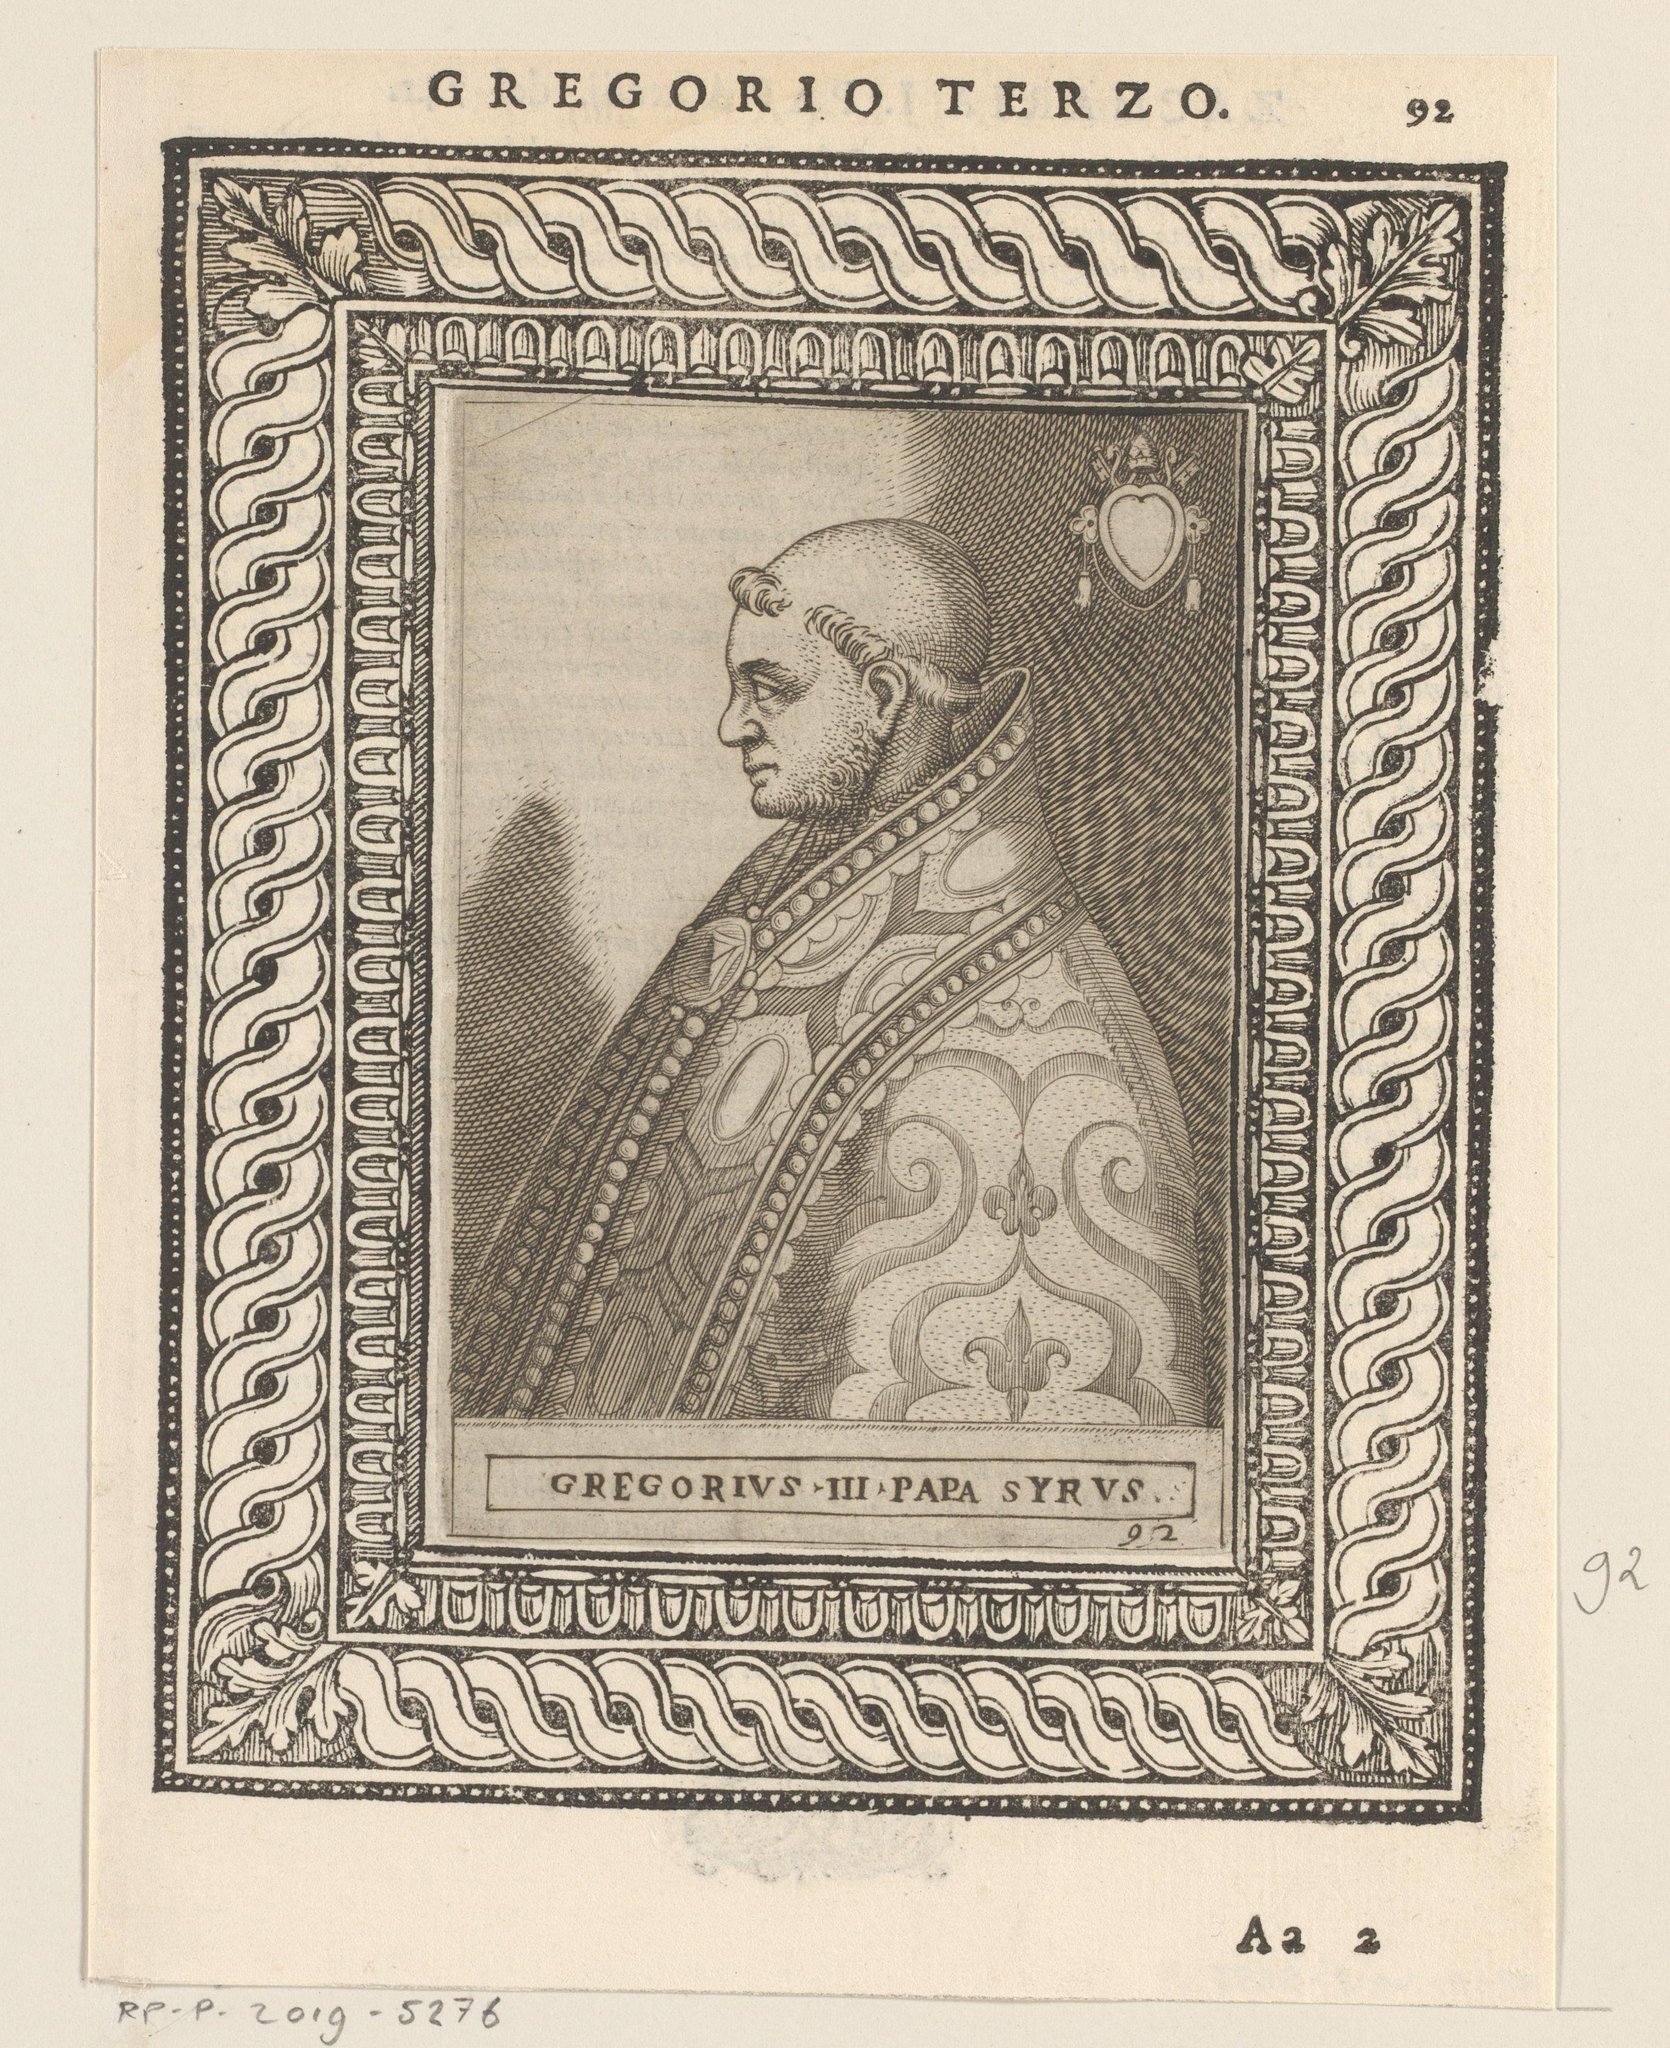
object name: print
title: Portret van paus Gregorius III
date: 1587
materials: paper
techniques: engraving, letterpress printing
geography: rome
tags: historical persons, pope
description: Prent uit: Ciccarelli, Antonio. Le vite de Pontefici di Antonio Ciccarelli (...). Rome: Domenico Basa, 1587. Prent voor het eerst verschenen in: Cavalieri, Giovanni Battista de'. Pontificum romanorum effigies (...). Rome: Domenico Basa en Francesco Zanetti, 1580. Prent ook gebruikt in latere publicaties.